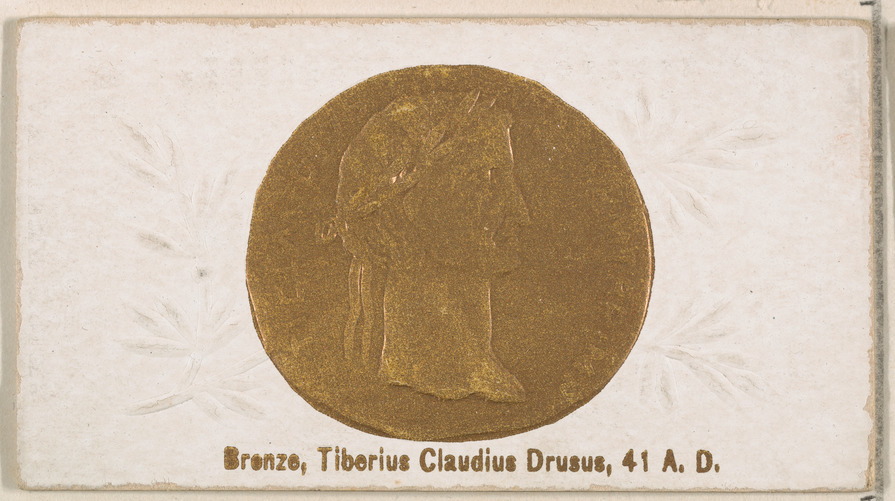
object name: print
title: Bronze, Tiberius Claudius Drusus, 41 A.D., from the Ancient Coins series (N180) issued by Wm. S. Kimball & Co.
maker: william s. kimball & company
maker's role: publisher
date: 1888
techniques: color lithograph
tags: men,coins